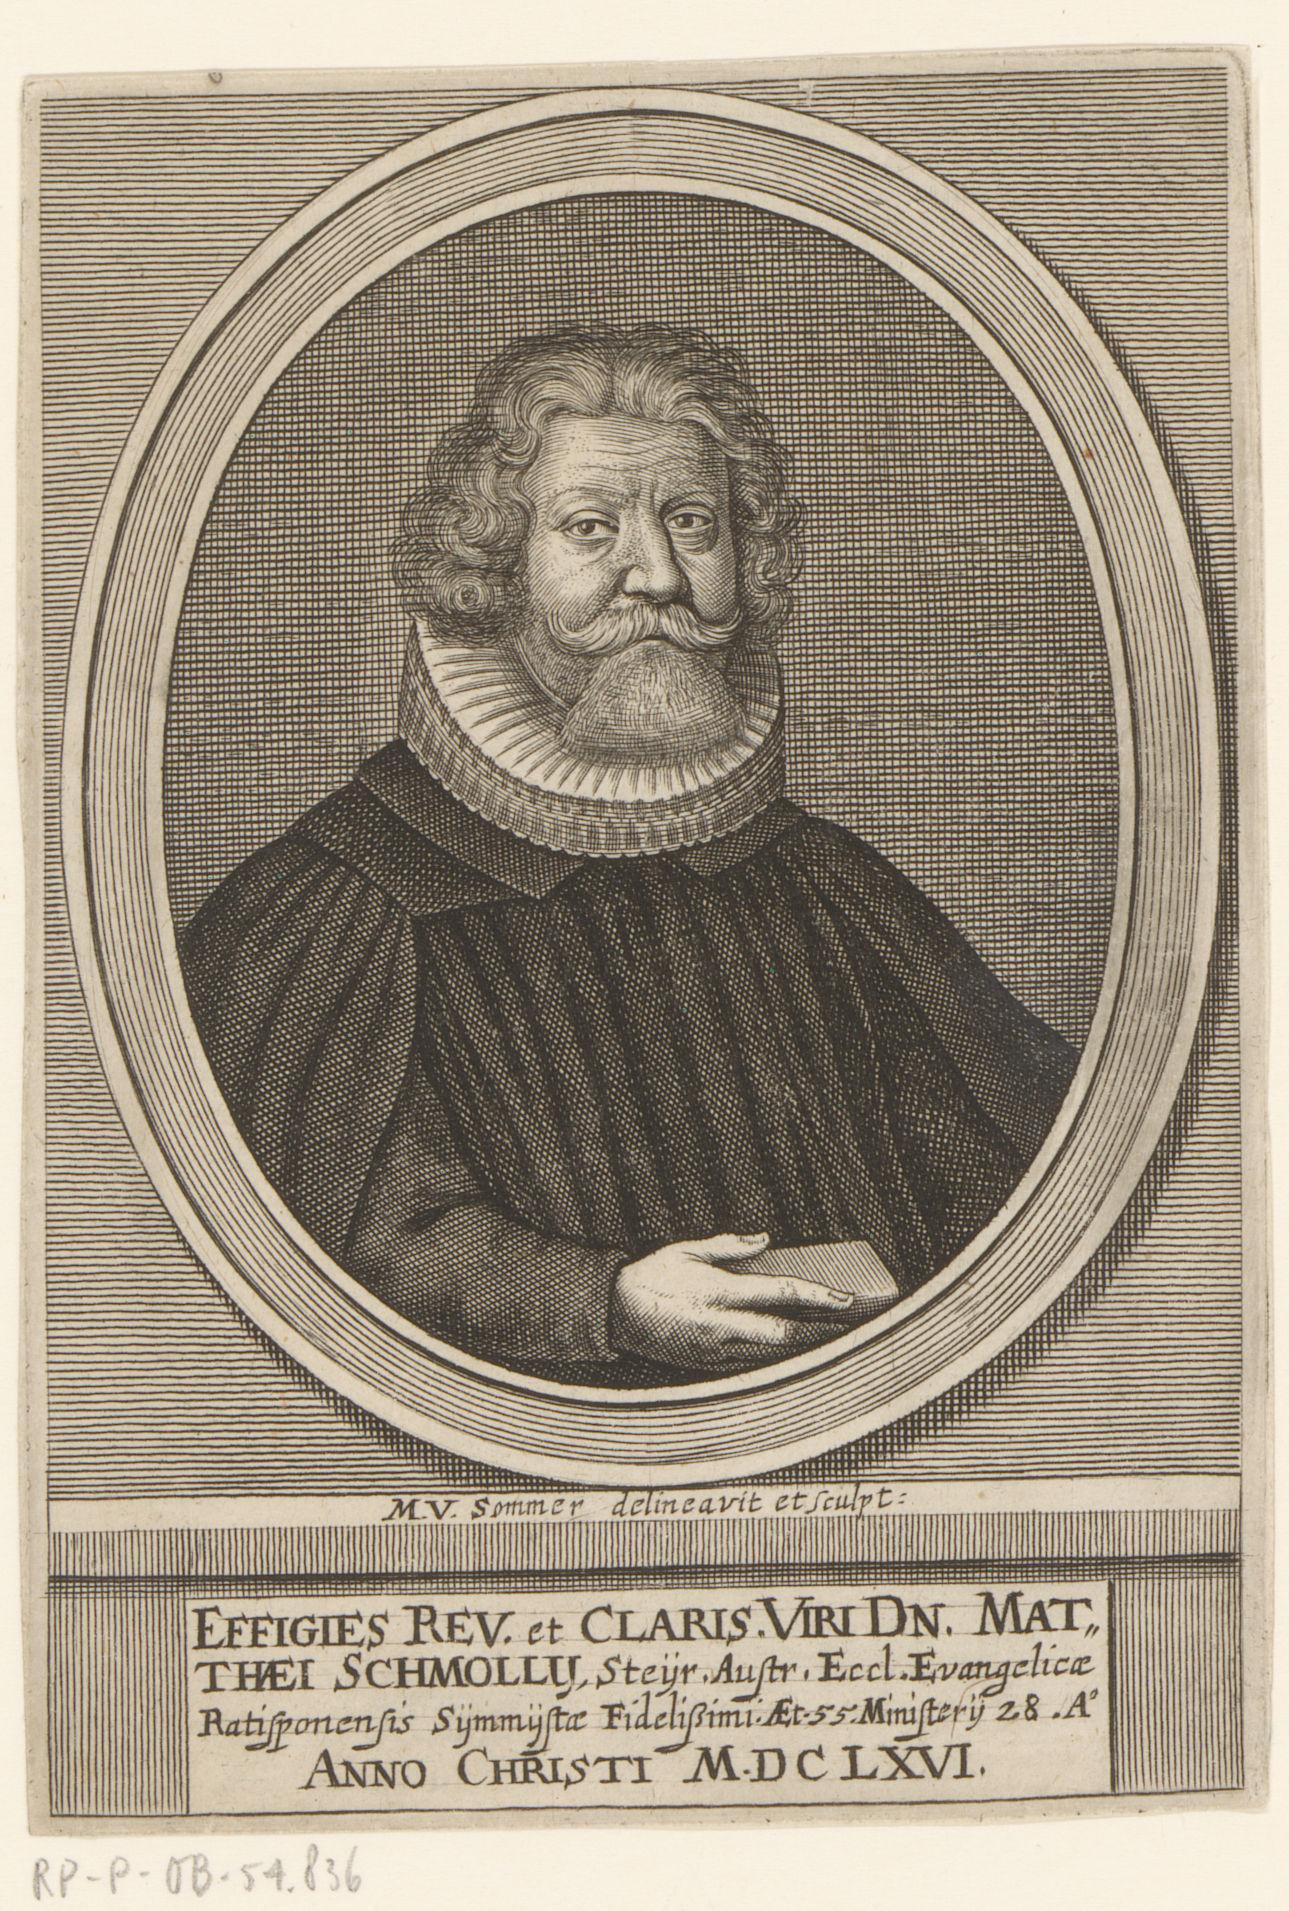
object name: print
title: Portret van Matthäus Schmoll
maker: matthias van sommer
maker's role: draughtsman, print maker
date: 1666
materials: paper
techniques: engraving, etching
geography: germany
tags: matthäus schmoll (ii), historical persons, book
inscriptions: collector's mark: Lugt 2228